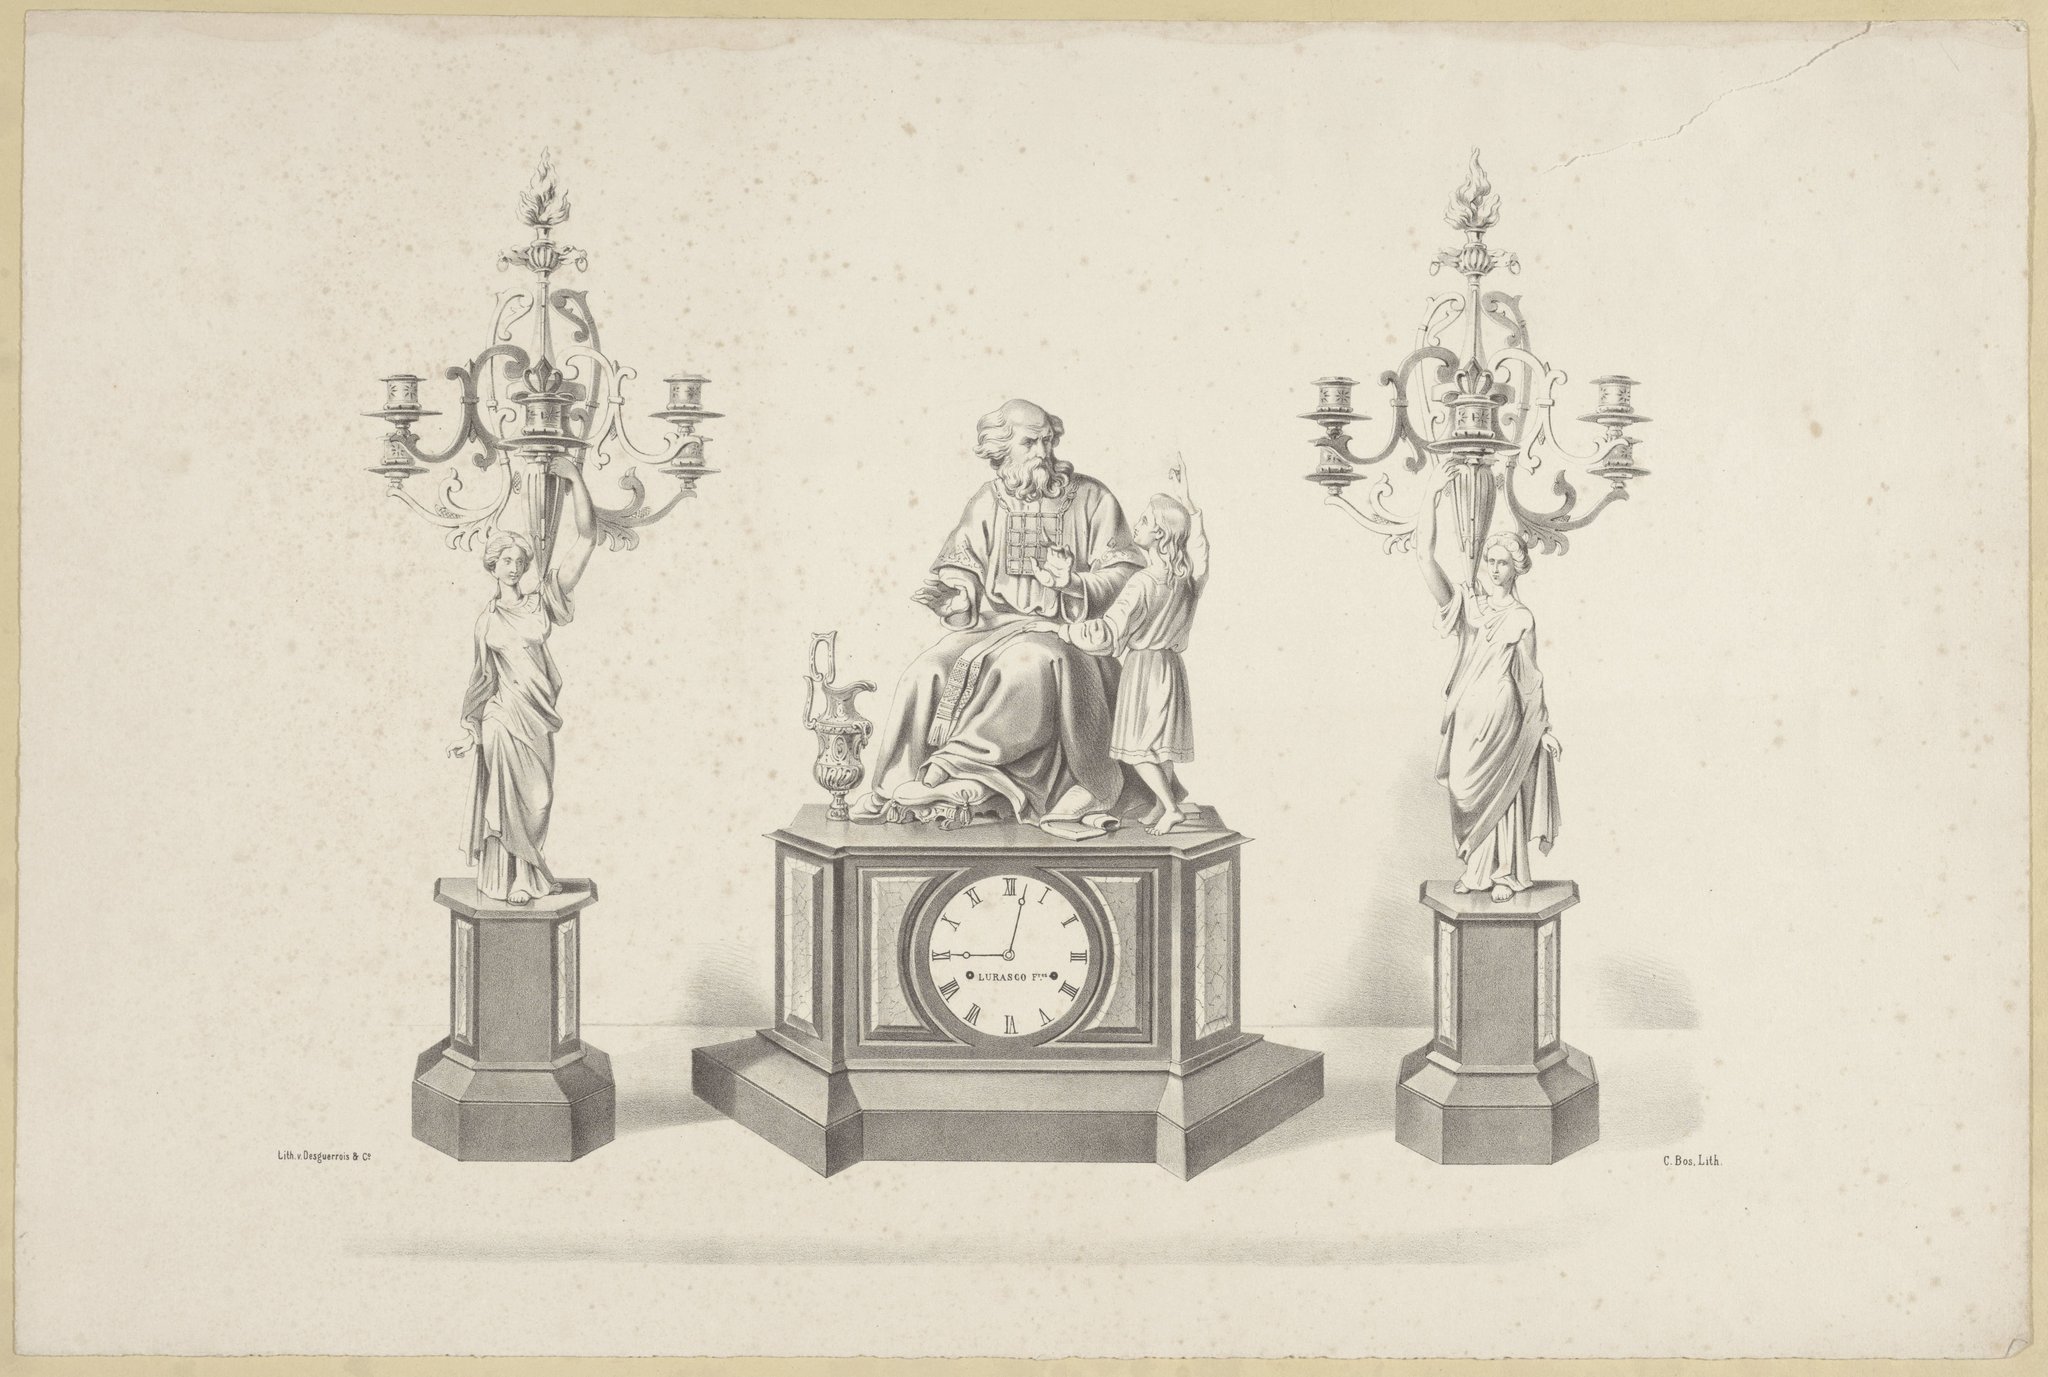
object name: print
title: Pendule en twee kandelaars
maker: christiaan bos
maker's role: draughtsman, print maker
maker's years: 1835-1918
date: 1845-1914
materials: paper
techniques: lithograph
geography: amsterdam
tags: old man, clock, candlestick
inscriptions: collector's mark: Lugt 2228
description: De kandelaars bestaan uit staande vrouwfiguren, gekleed in lange gewaden, op een sokkel. Zij houden respectievelijk hun linker- en rechteram omhoog. Op de pendule zit een oude man. Hij draagt een ketting met een vierkant rooster en rust met zijn voet op een kussen. Links van hem staat een karaf, rechts een jongeman die met zijn rechterarm omhoog wijst. De wijzerplaat is gemerkt door de vervaardigers Frères Lurasco.